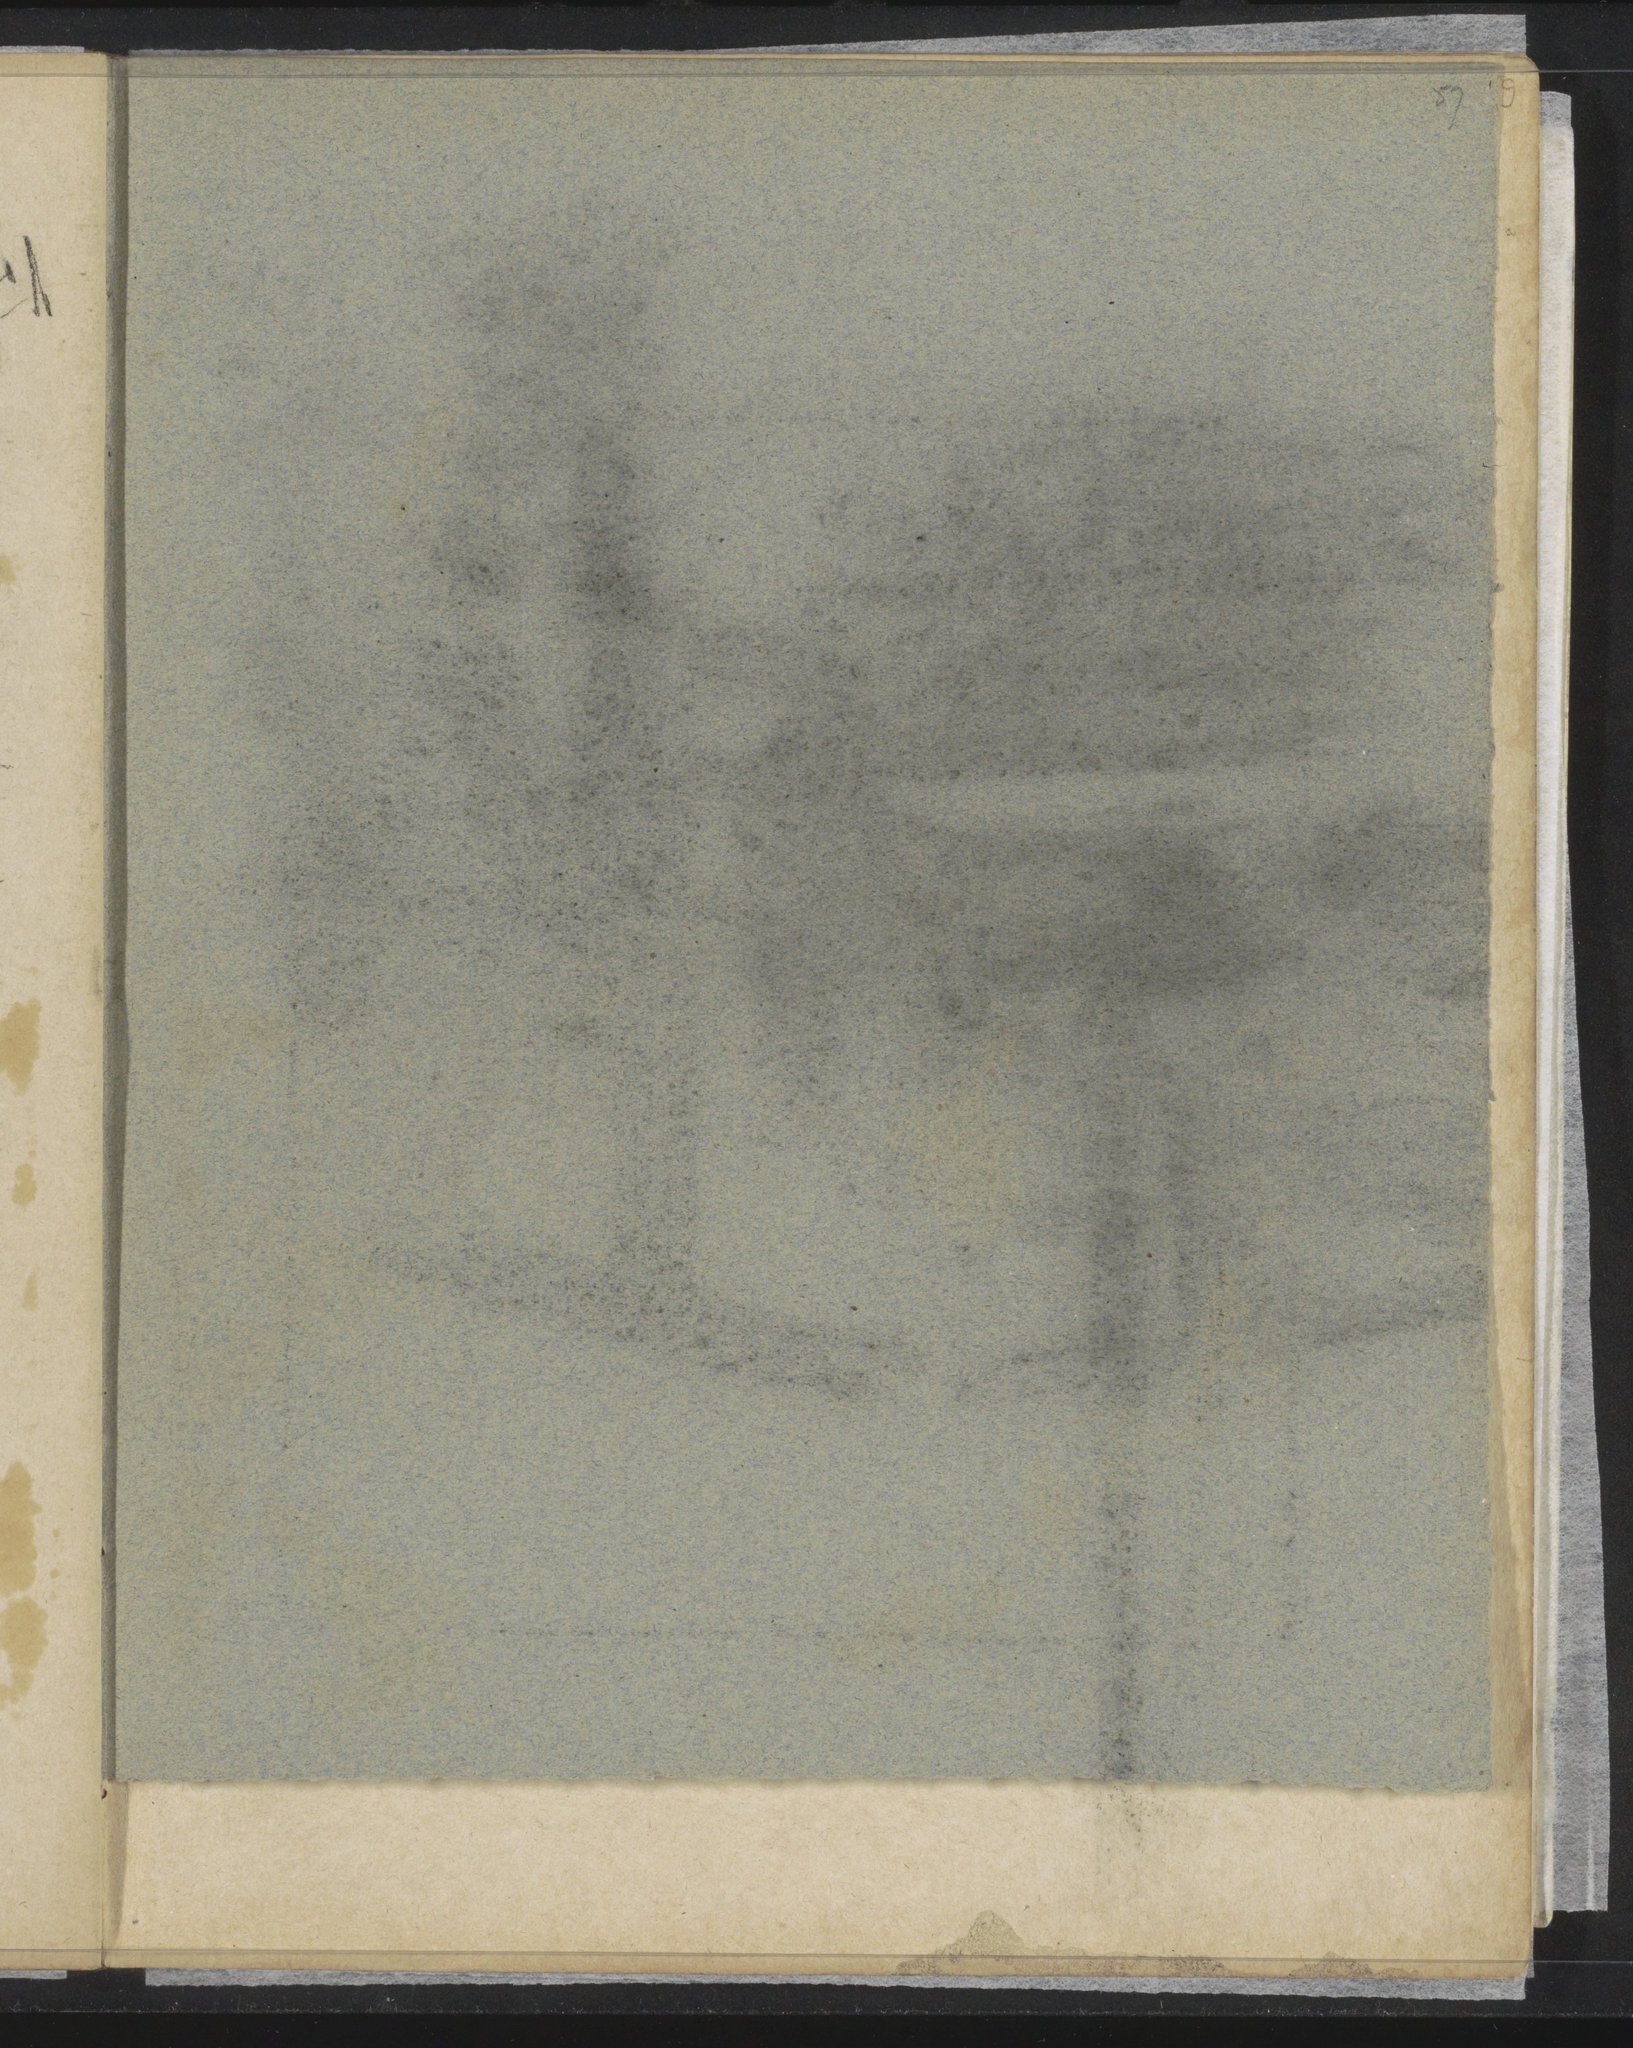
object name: sketchbook leaf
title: Abklatsch van de krijttekening op pagina 56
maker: willem witsen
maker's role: draughtsman, painter, print maker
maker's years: 1860-1923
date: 1887-1891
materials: paper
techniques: printmaking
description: Pagina 57 uit een schetsboek met 29 bladen.